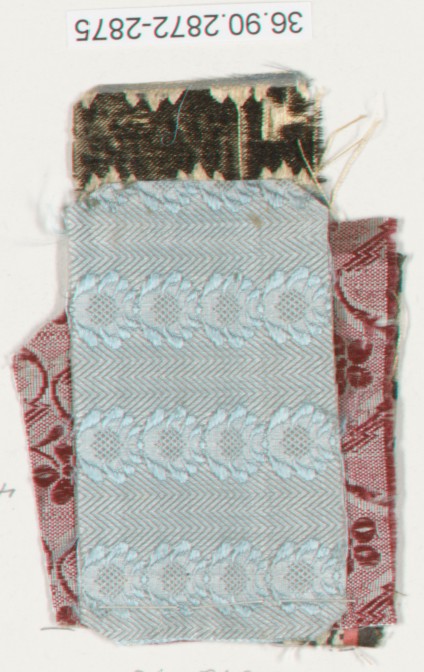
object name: piece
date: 1801-1900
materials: silk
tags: flowers